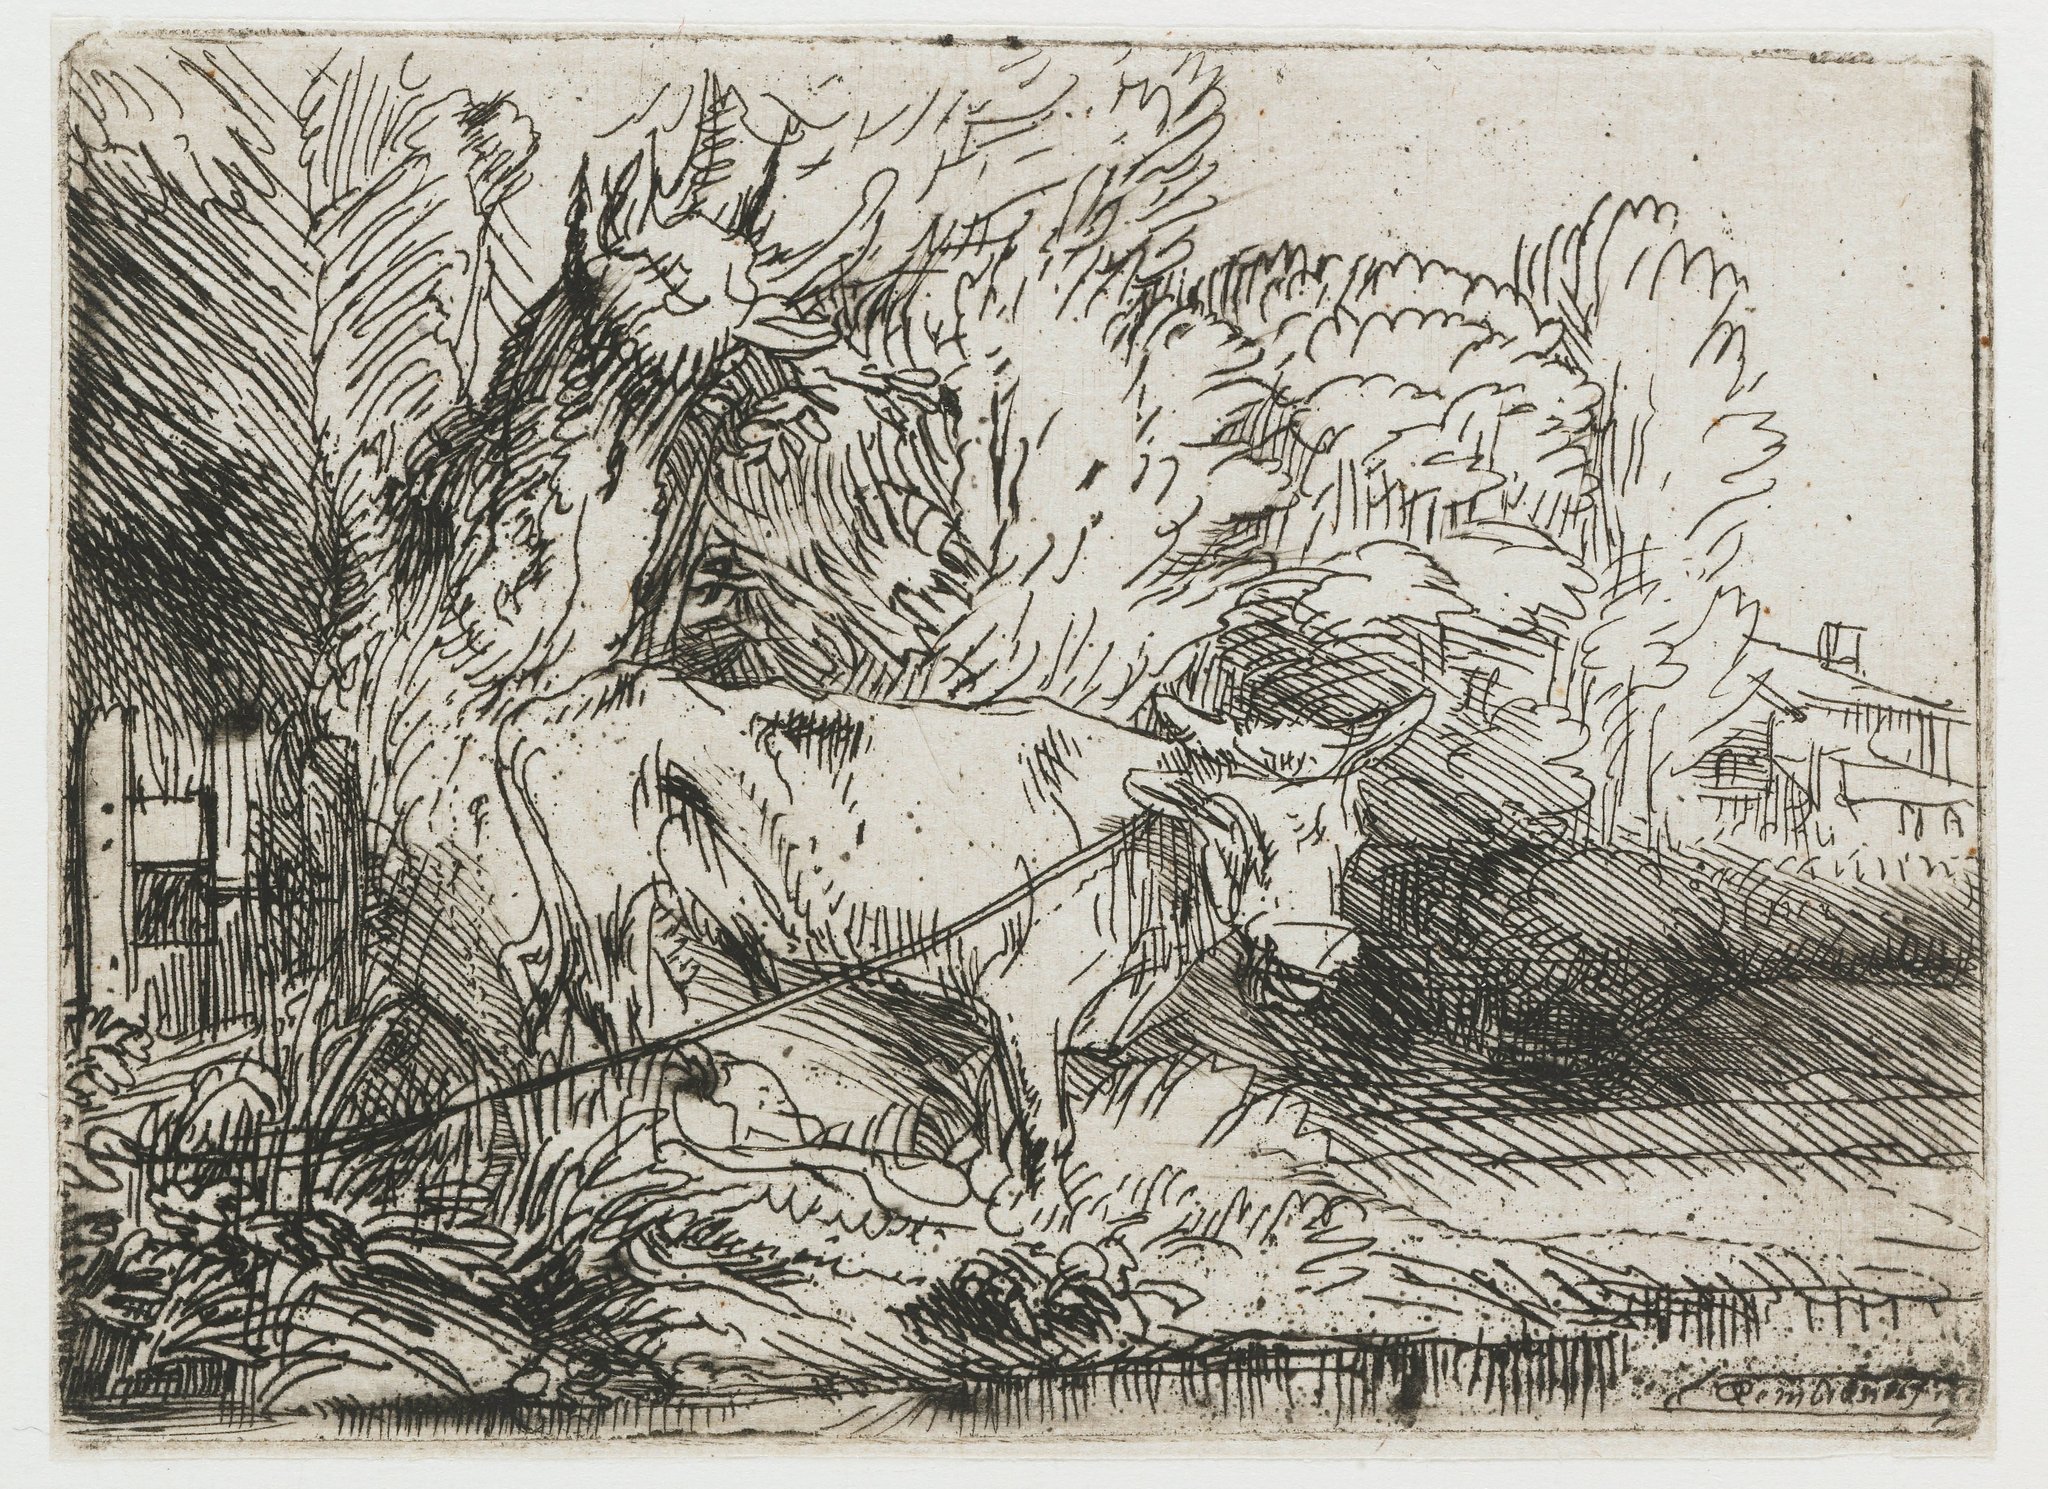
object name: print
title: The Bull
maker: rembrandt van rijn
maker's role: draughtsman, painter, print maker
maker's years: 1606-1669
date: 1651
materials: paper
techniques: etching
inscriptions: signature and date: ‘Rembrandt f 165’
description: While on his walks in the surroundings of Amsterdam, Rembrandt came upon not only dwellings and natural settings, but also many animals. He saw this young creature standing at the water’s edge and probably captured it on the etching plate on the spot. He had made a drawing of a similar subject about ten years earlier.